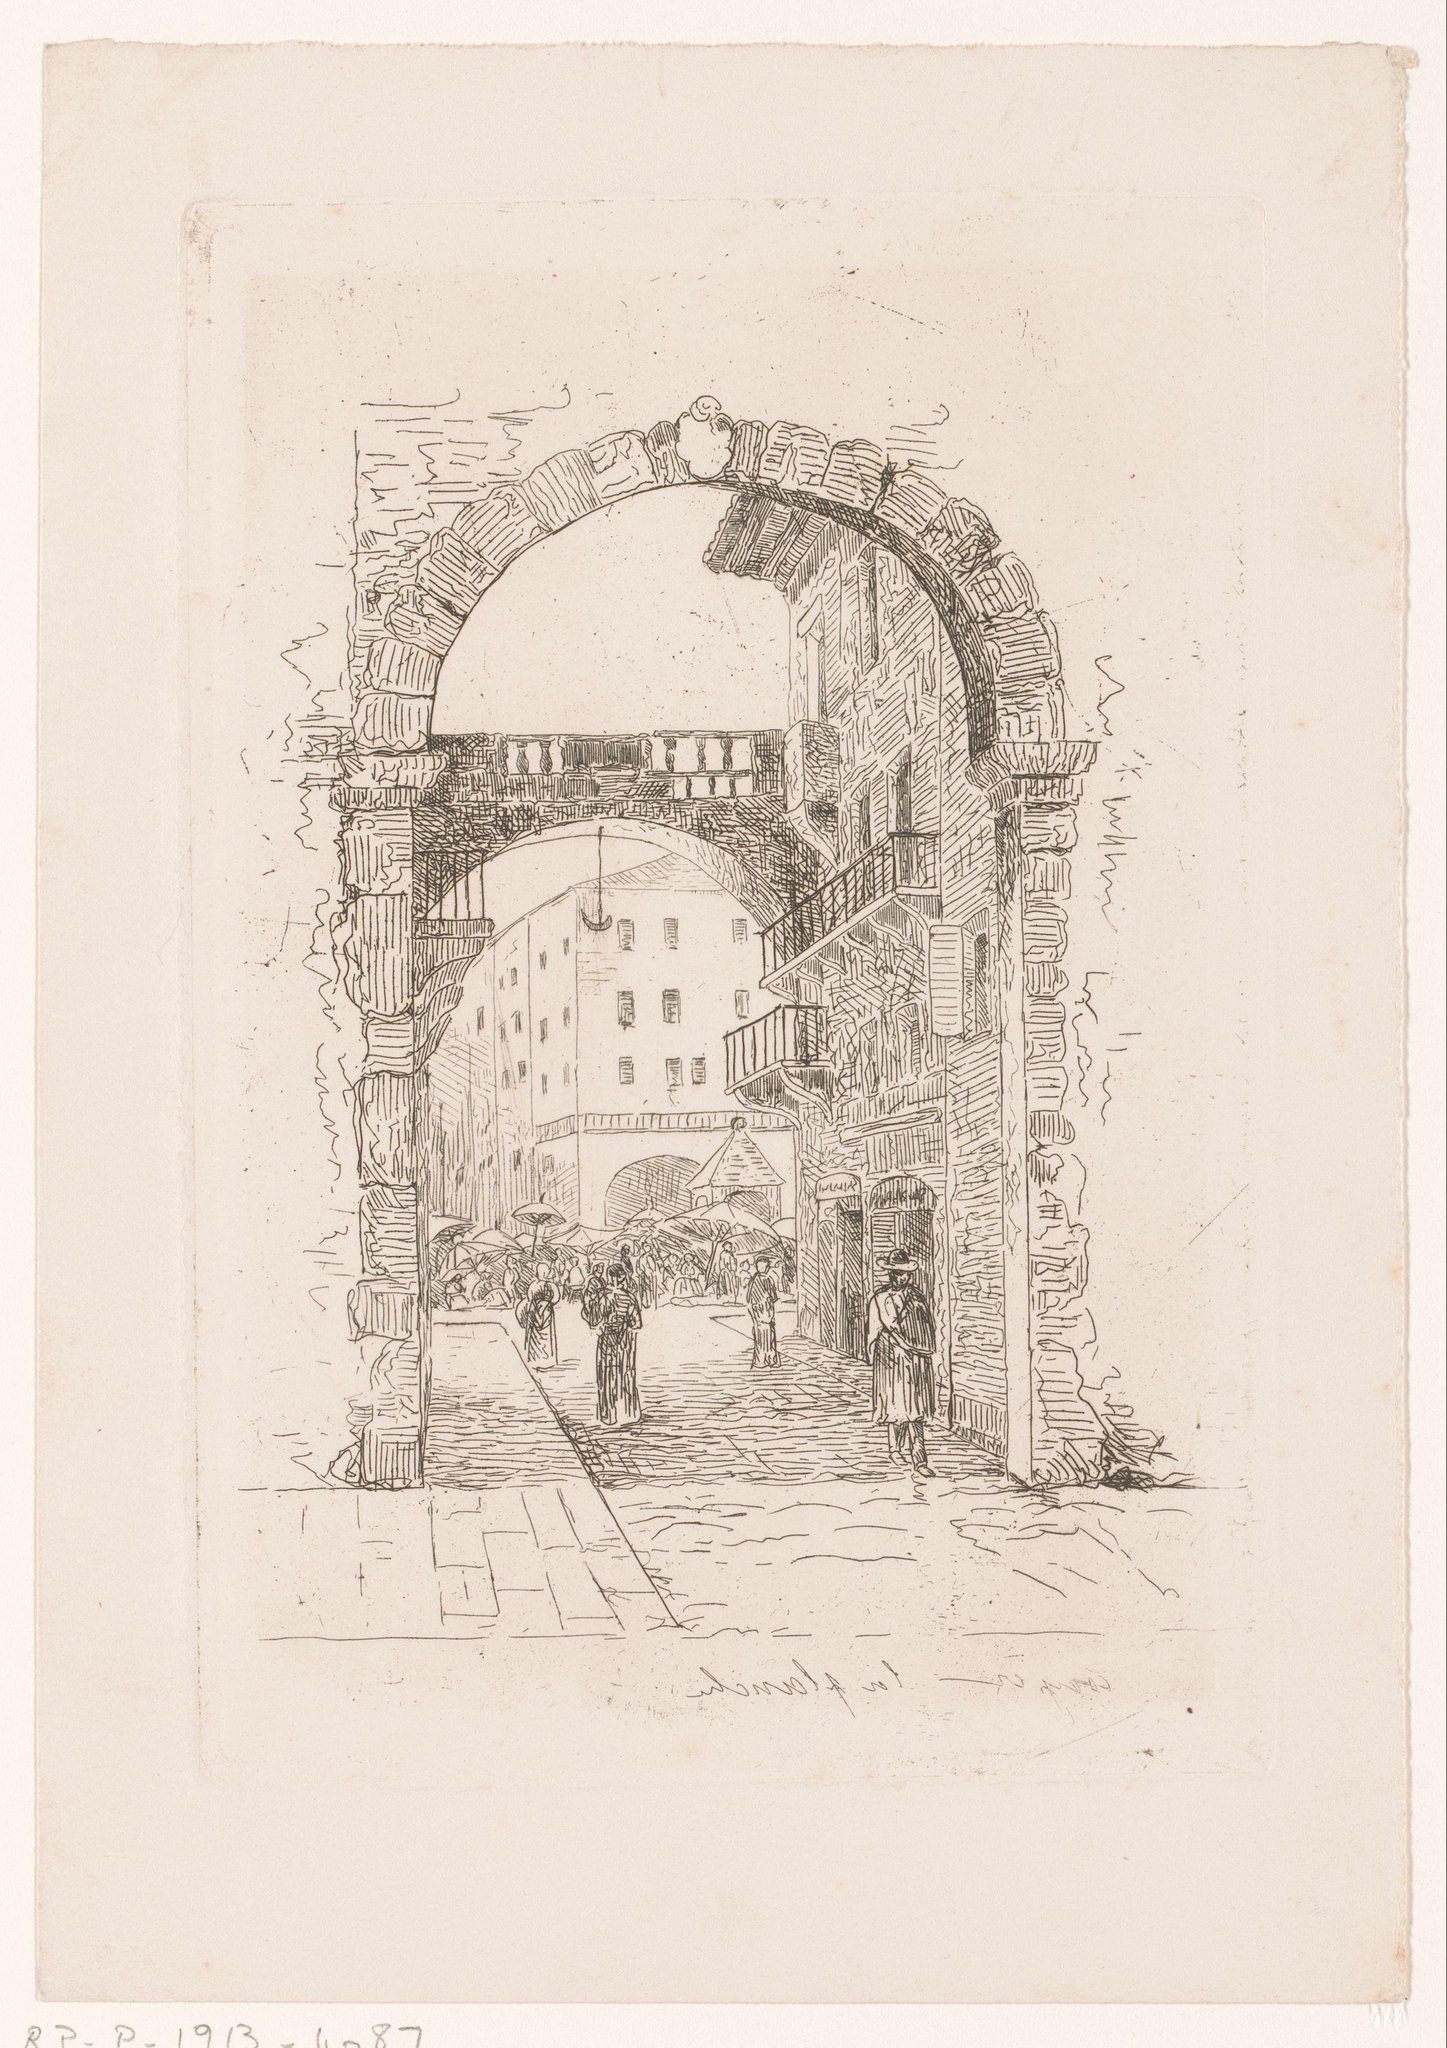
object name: print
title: Gezicht op het Piazza dei Signori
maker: maria van hohenzollern-sigmaringen (gravin van vlaanderen)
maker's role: print maker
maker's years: 1845-1912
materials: paper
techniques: etching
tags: market, street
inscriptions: collector's mark: Lugt 2228